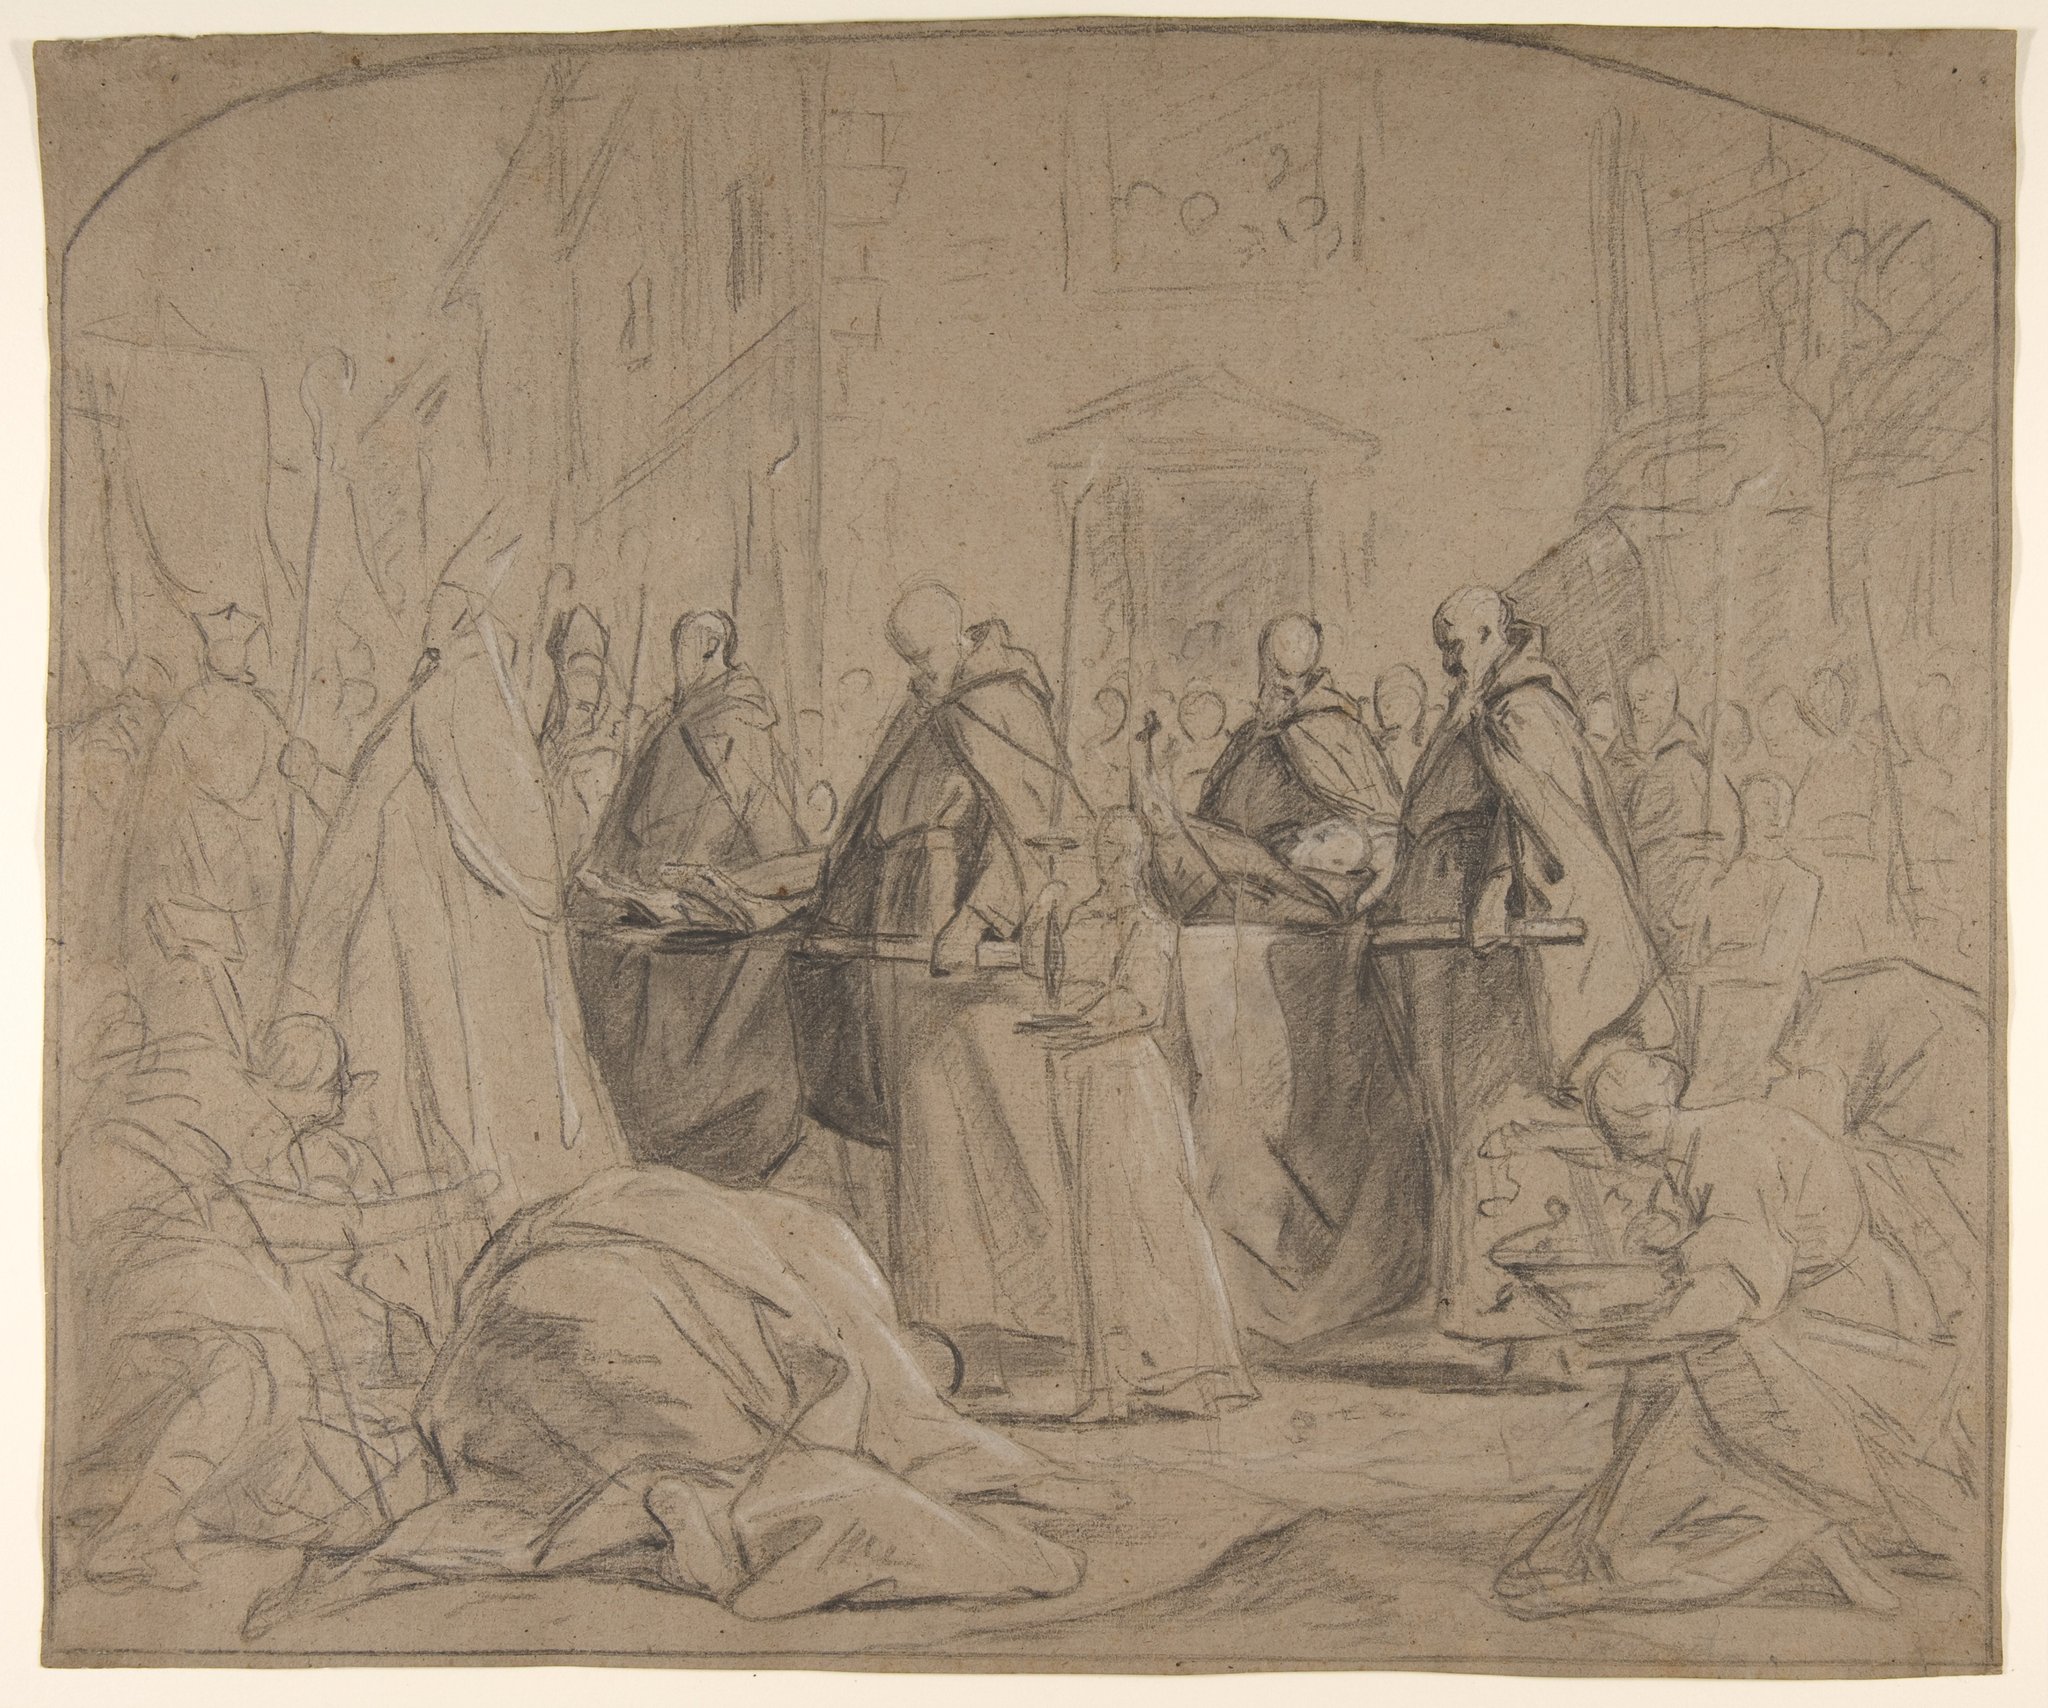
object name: drawing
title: Funeral of François Duplessis de Mornay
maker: jean restout le jeune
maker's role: artist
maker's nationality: french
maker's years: 1692-1768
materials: chalk, paper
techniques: heightening, incising, transfer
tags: men,funerals